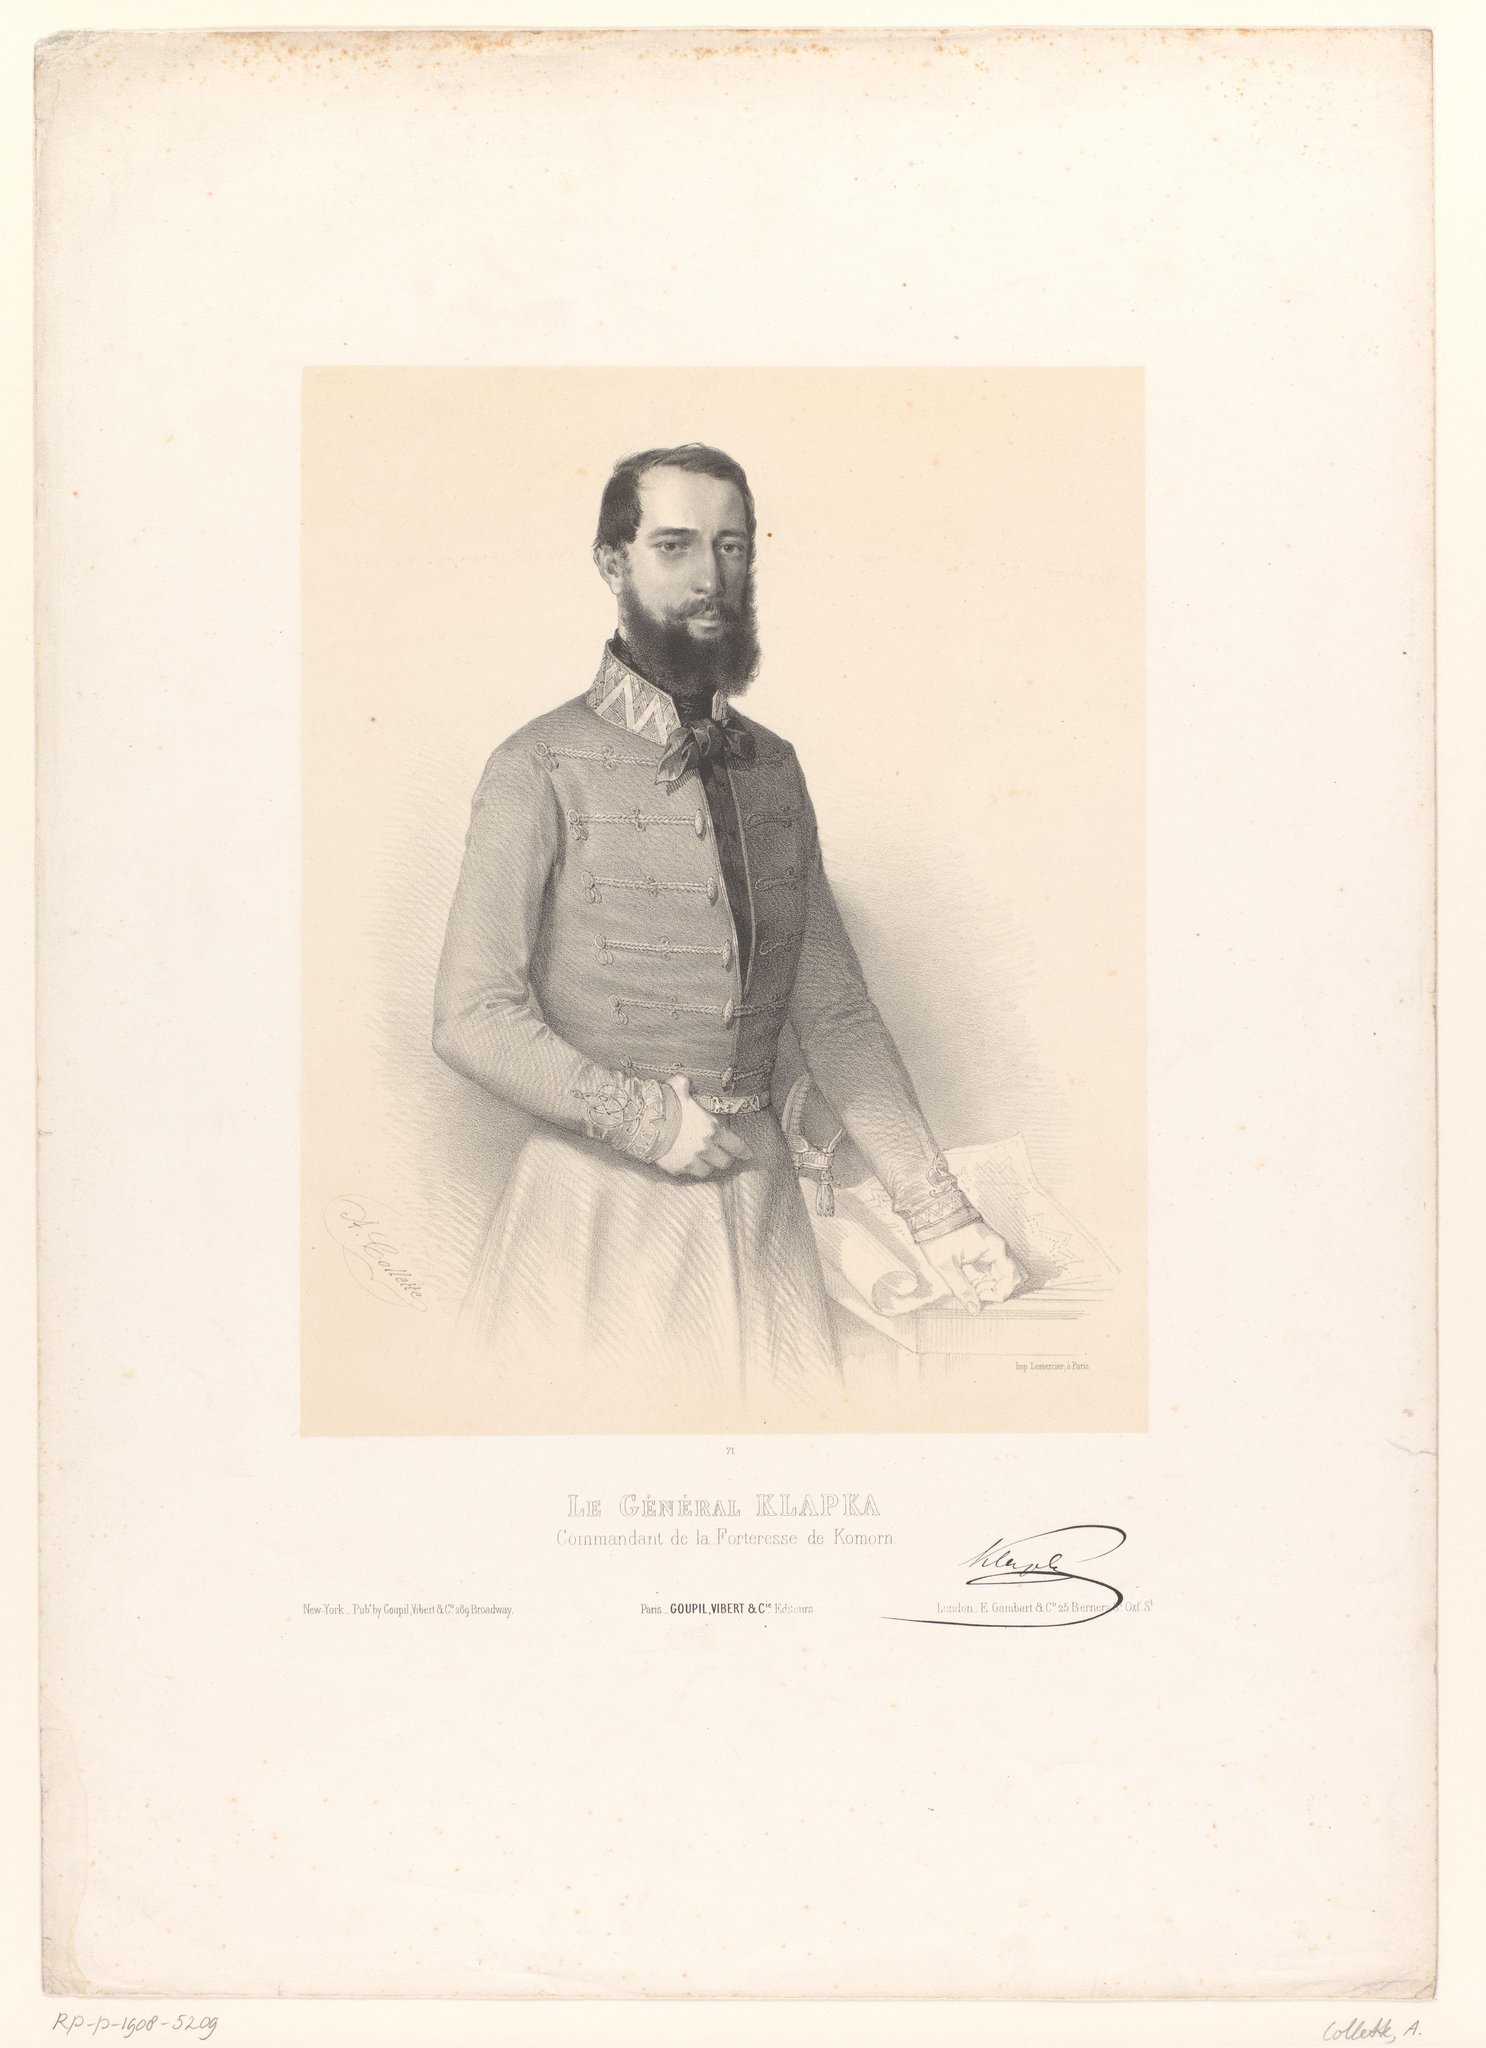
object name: print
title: Portret van generaal György Klapka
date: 1849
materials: paper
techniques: lithograph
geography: new york city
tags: historical persons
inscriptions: check stamp: Lugt 5004, collector's mark: Lugt 2228a